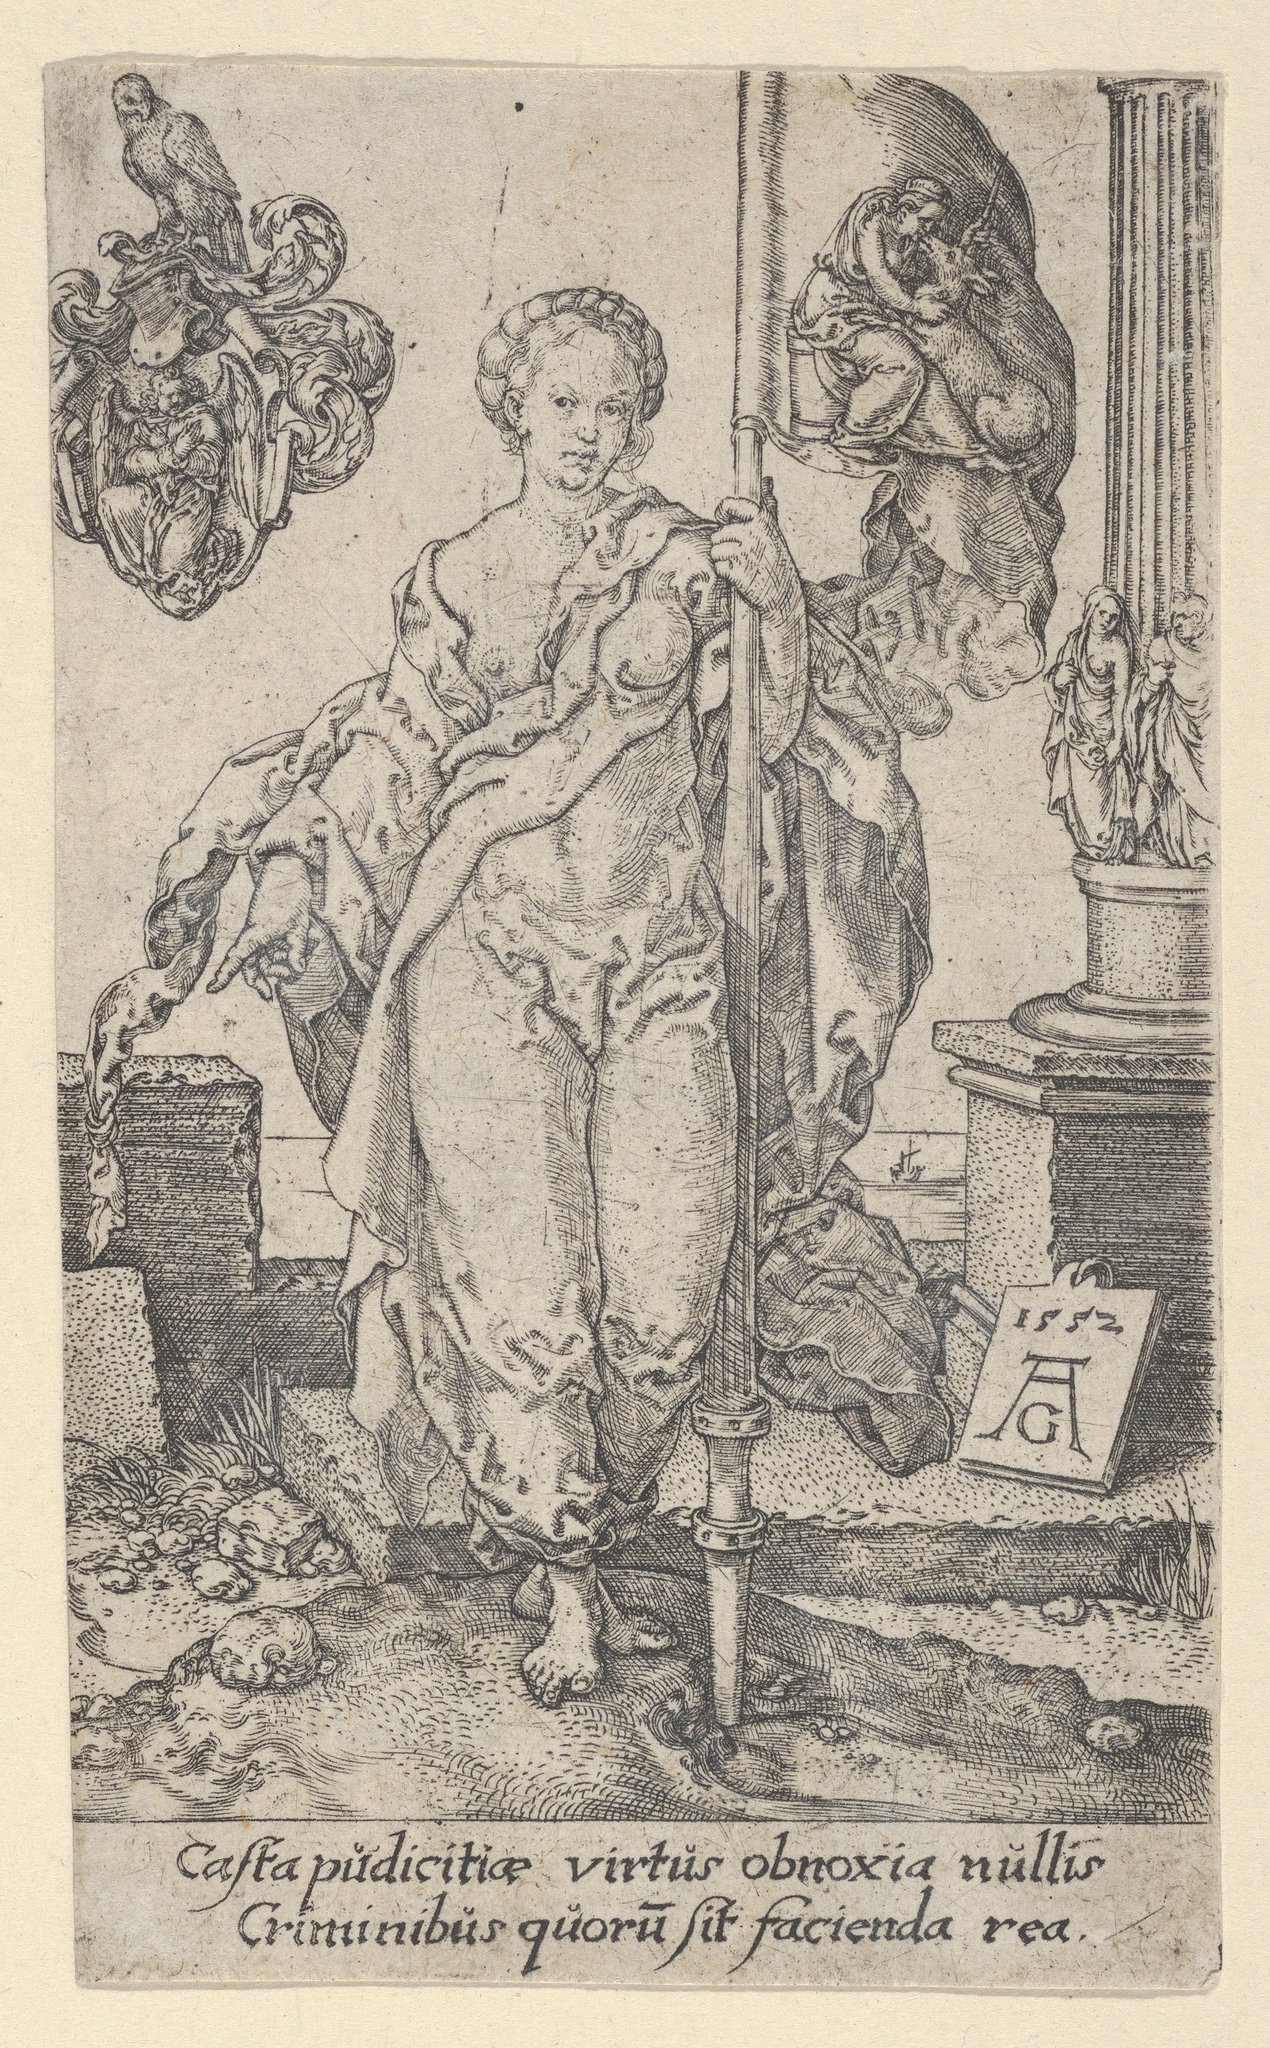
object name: print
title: Chastity, from "The Virtues"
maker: heinrich aldegrever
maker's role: artist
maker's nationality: german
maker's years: 1502-1561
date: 1552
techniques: engraving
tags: birds,female nudes